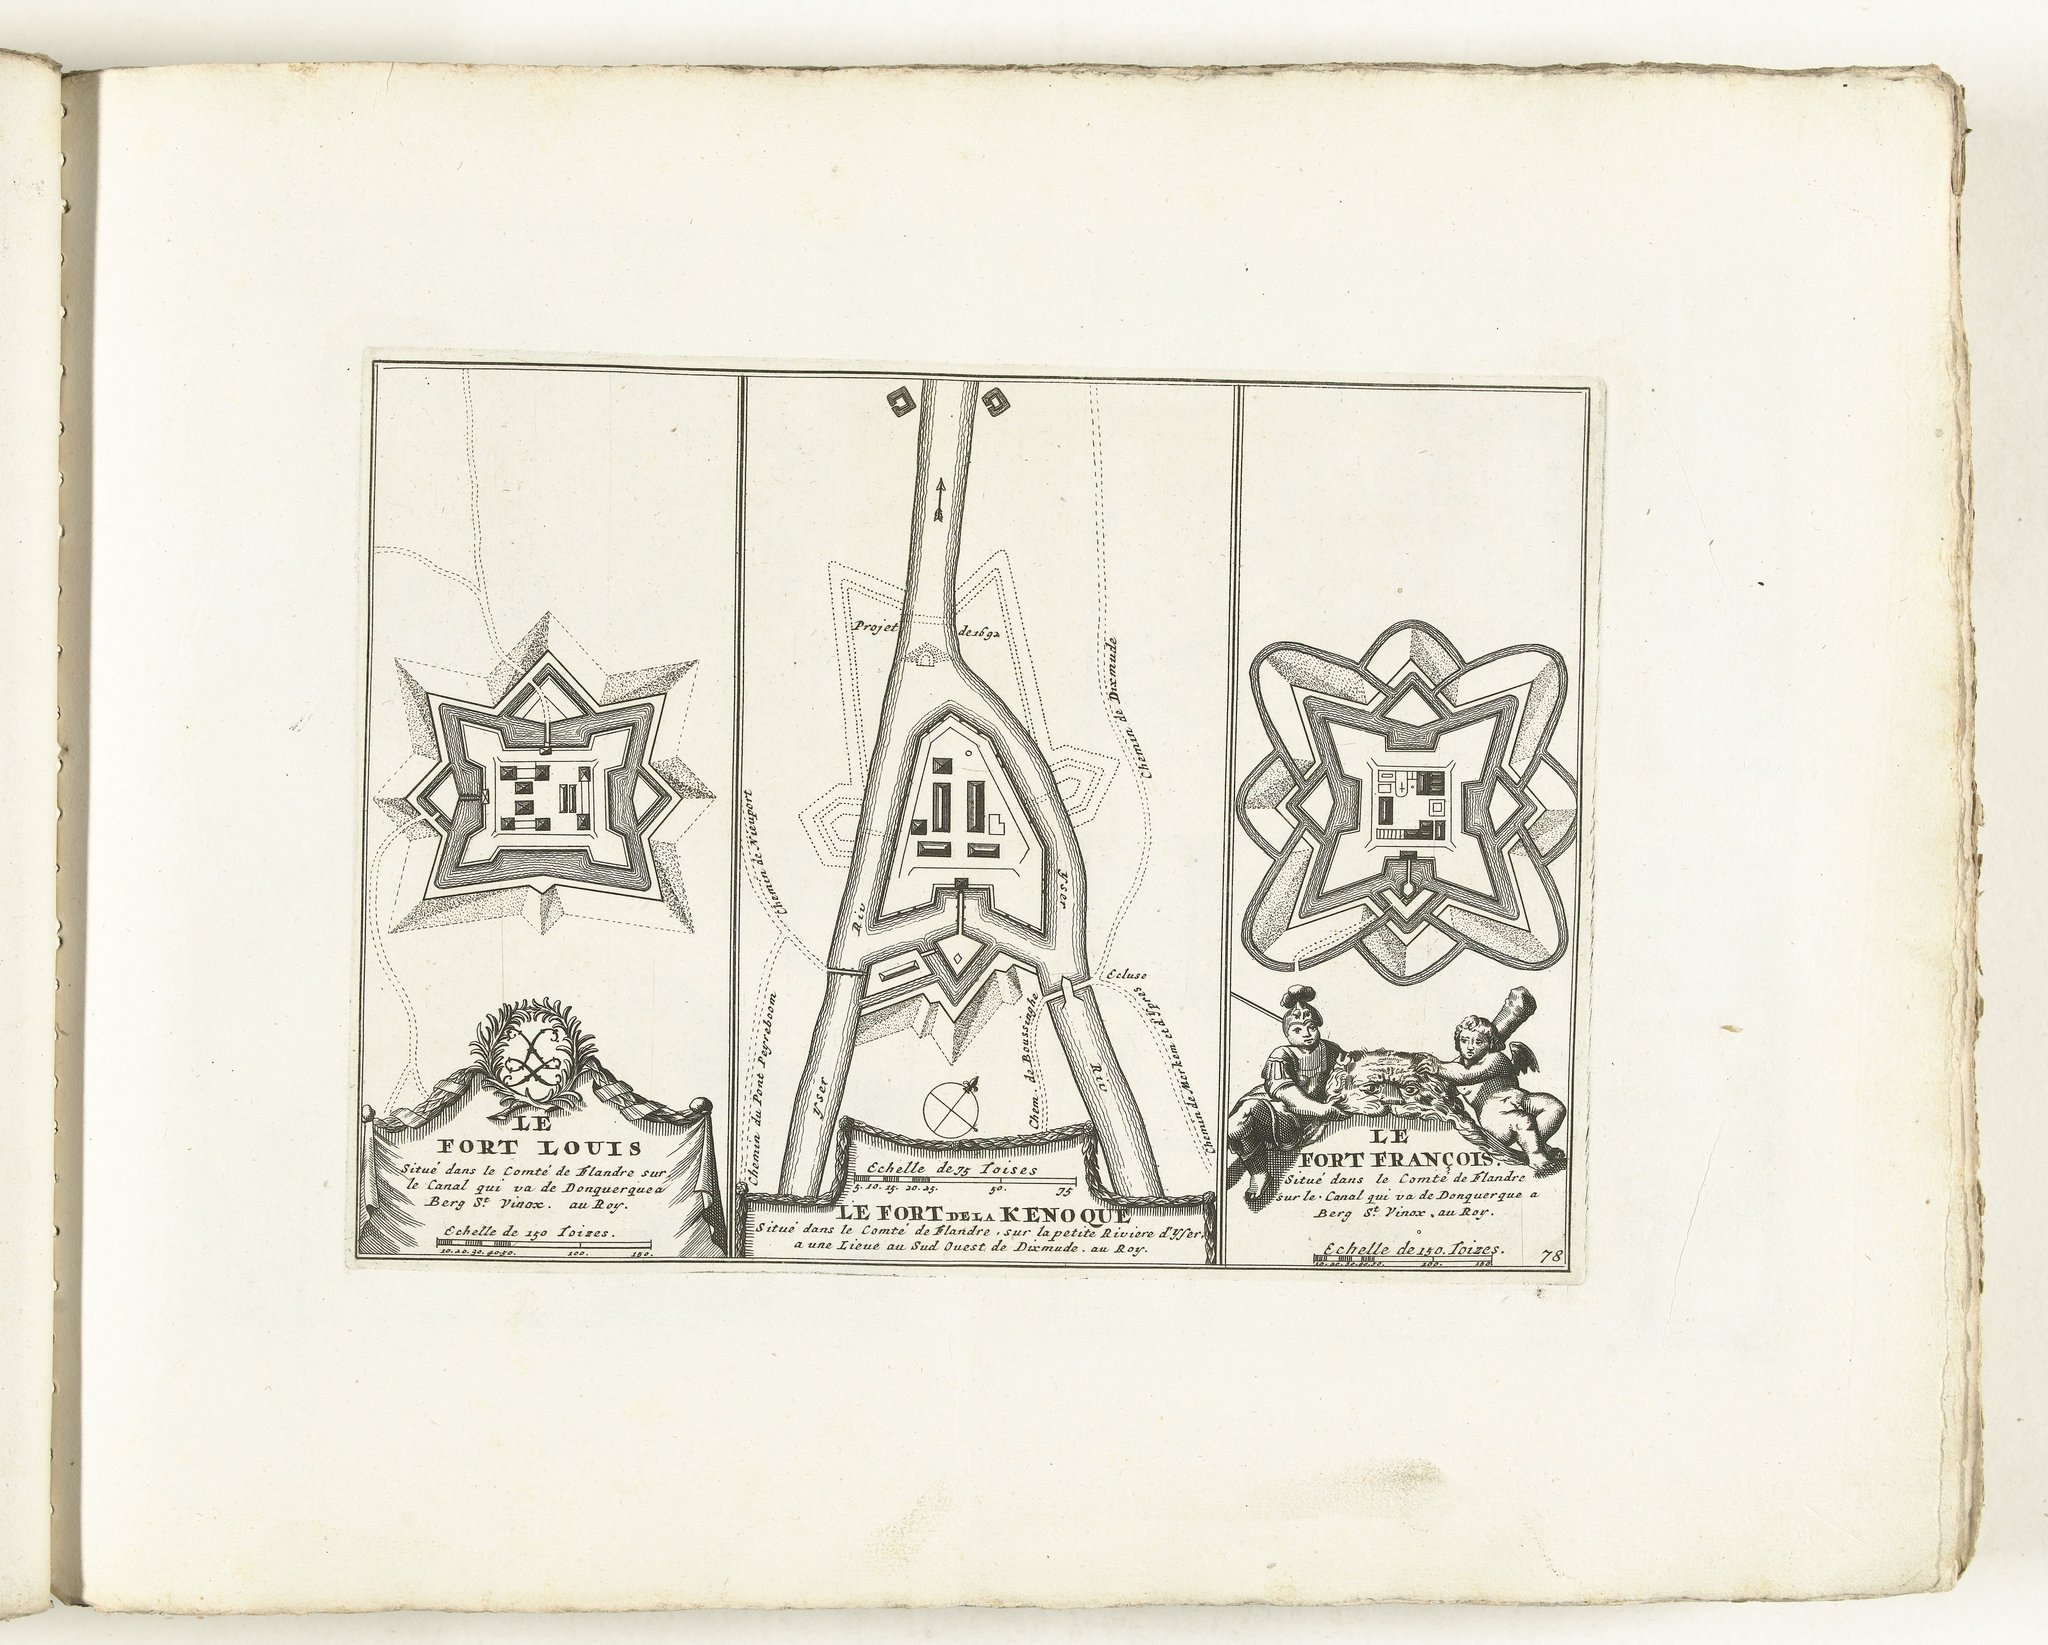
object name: print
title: Les Forces de l'Europe, Asie, Afrique et Amerique, ou description des principales villes avec leurs fortifications. Dessignées par les meilleurs ingenieurs, particulierement celles qui sont sous la domination de la France (...) et ornées de plusieurs superbes edifices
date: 1702-1703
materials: paper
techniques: etching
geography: amsterdam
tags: fortress, maps of cities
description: De plattegronden van drie Franse forten in Vlaanderen. Plaat nr. 78 in het prentwerk bestaande in totaal uit 276 genummerde platen van vermaarde sterke steden en vestingen in het kader van de Spaanse Successieoorlog. Voor het merendeel zijn deze platen gekopieerd naar de anonieme Franse platen: in Les forces de l'Europe en in: Le theatre de la guerre, dans les Pays-Bas, beide oorspronkelijk uitgegeven door Nicolas de Fer te Parijs (1693-1697) in het kader van de Negenjarige Oorlog. Titel en opschriften in de plaat in het Frans.